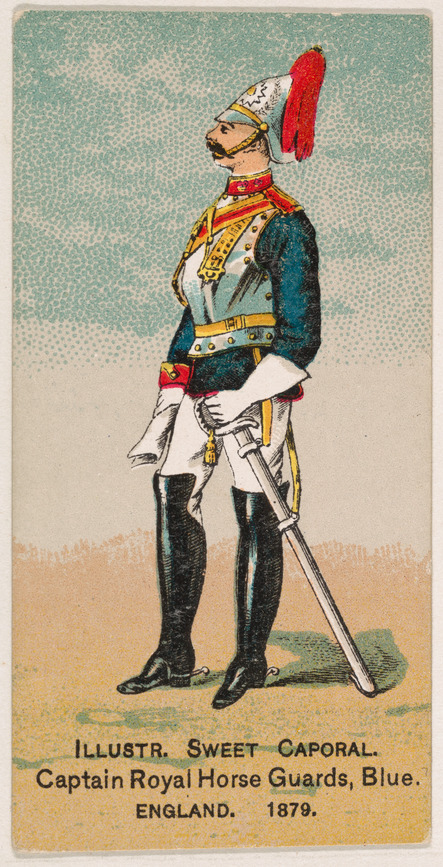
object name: print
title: Captain, Royal Horse Guards, Blue, England, 1879, from the Military Series (N224) issued by Kinney Tobacco Company to promote Sweet Caporal Cigarettes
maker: kinney brothers tobacco company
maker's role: publisher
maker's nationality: american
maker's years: 1869-2011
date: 1888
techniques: color lithograph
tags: military,men,profiles